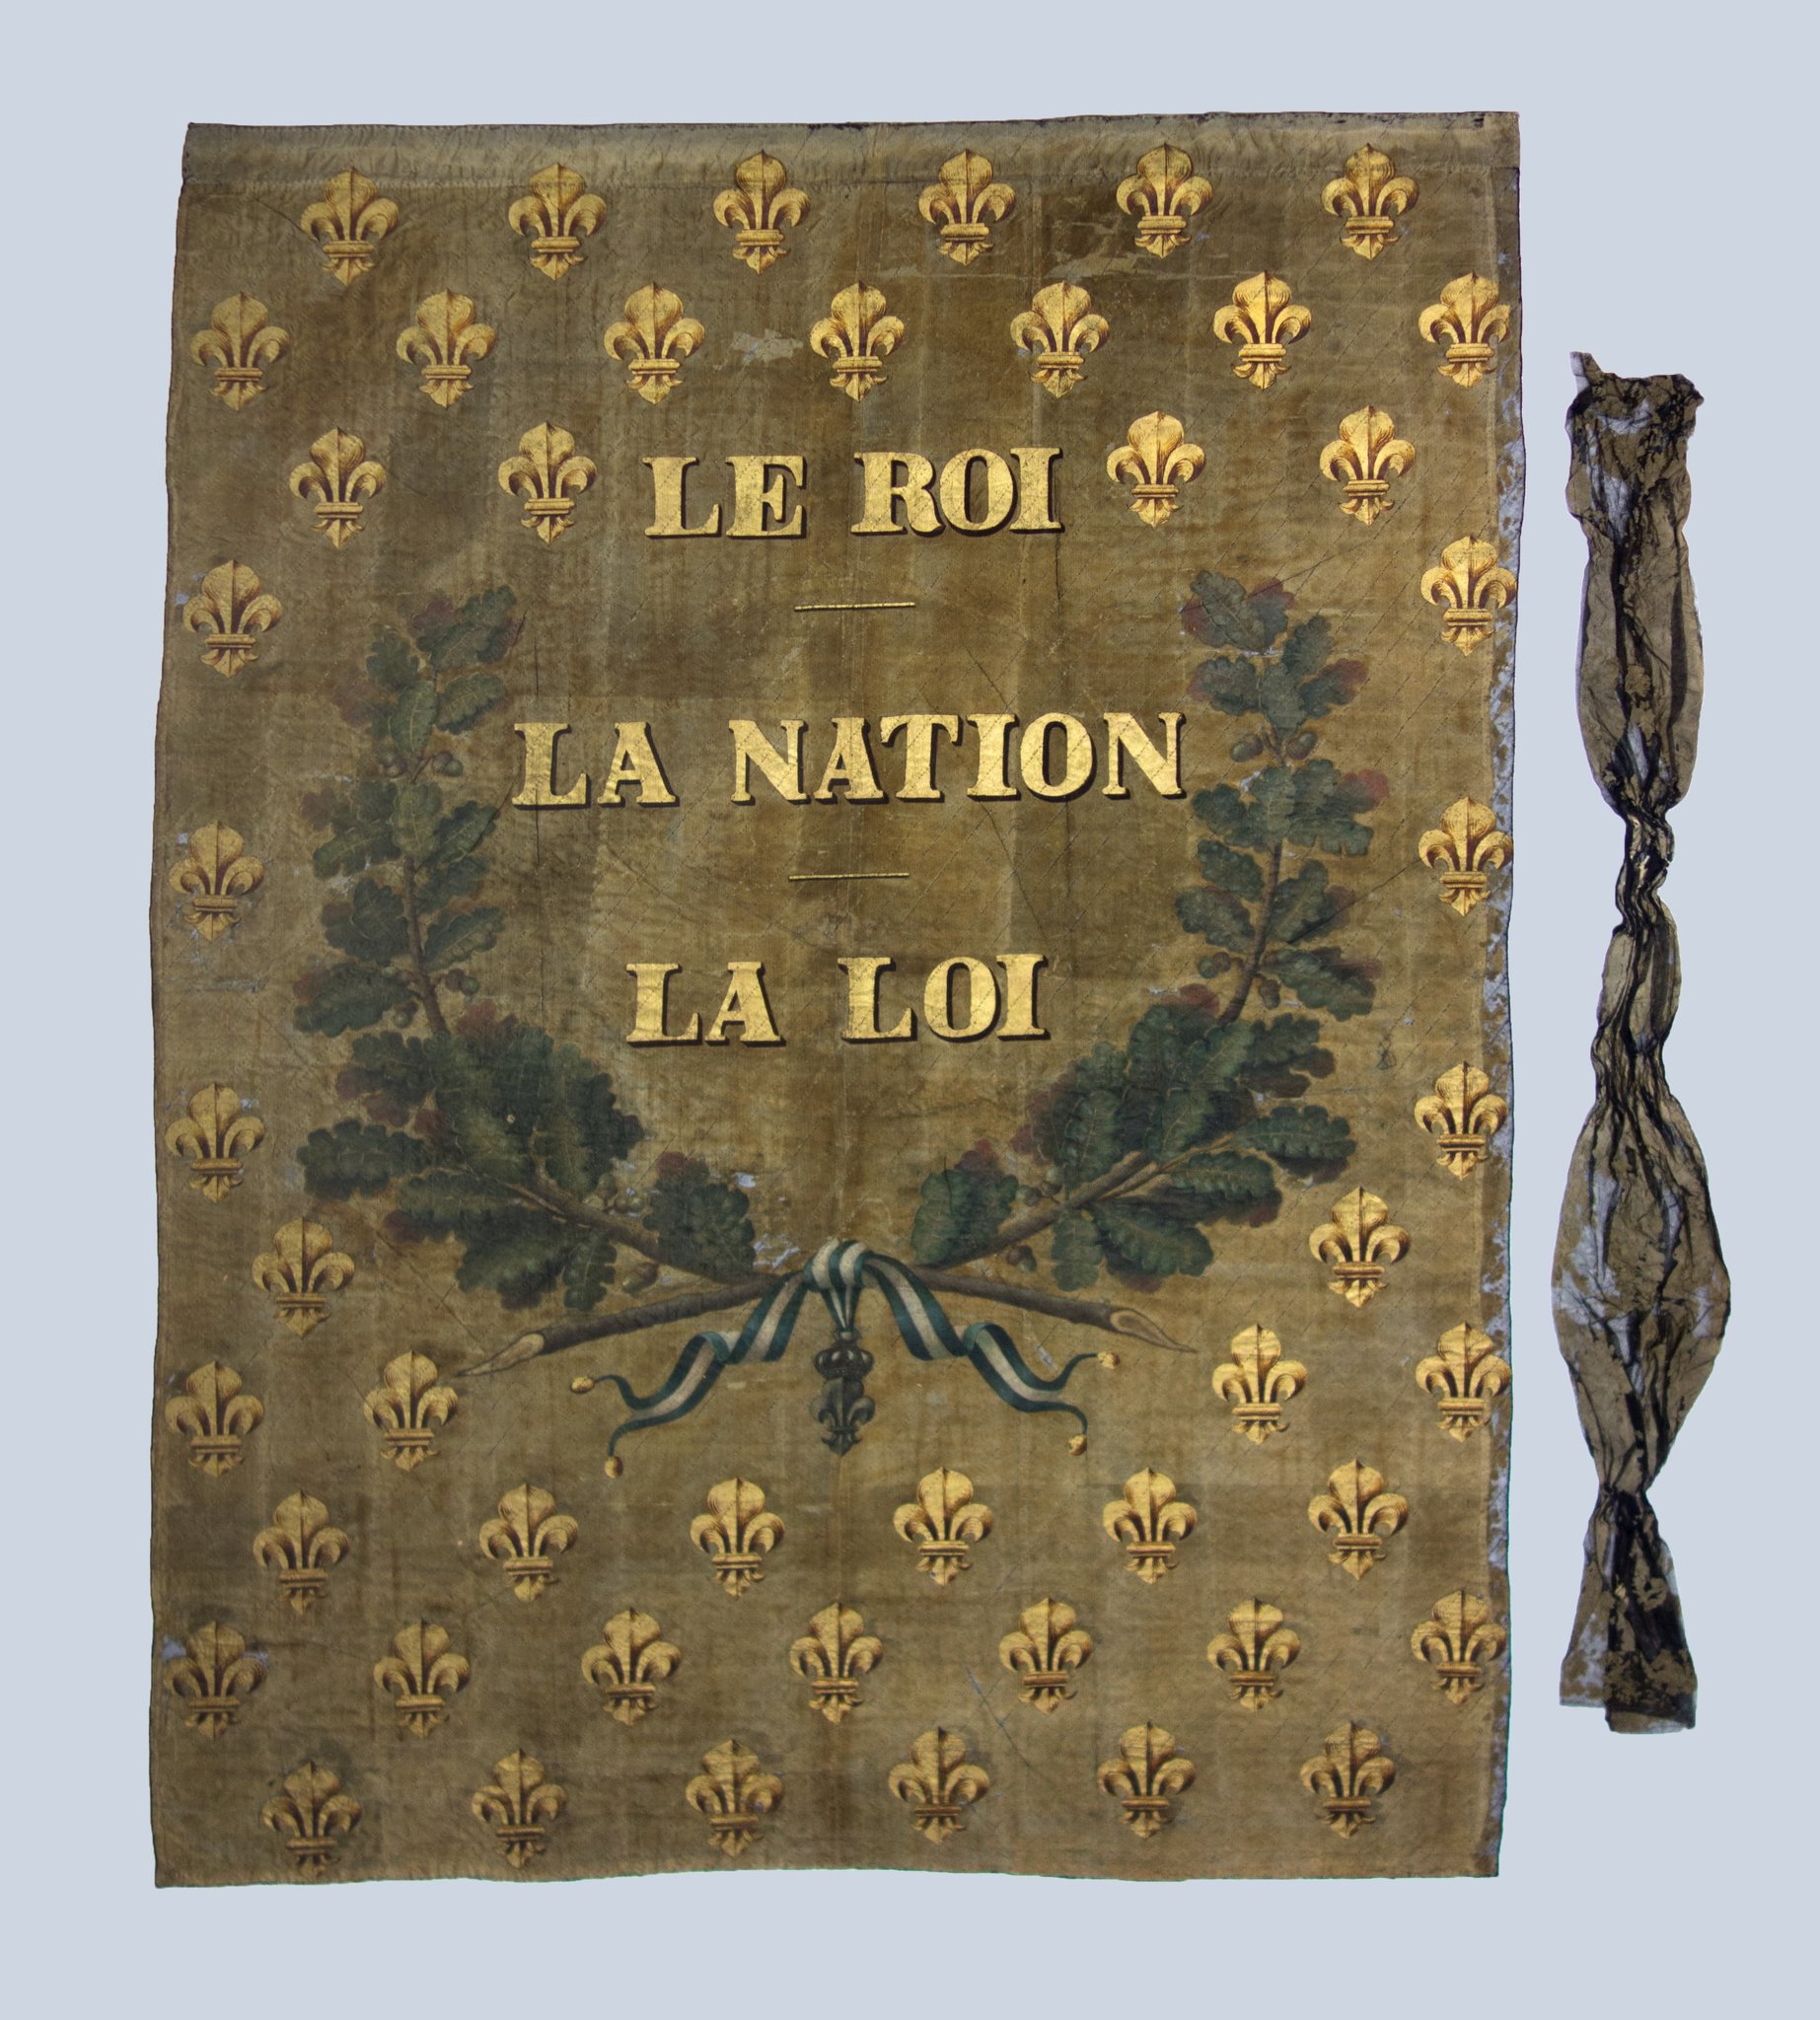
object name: banner with tassel and shaft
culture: french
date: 1701-1800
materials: brass, gold, pigment, textile, wood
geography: france